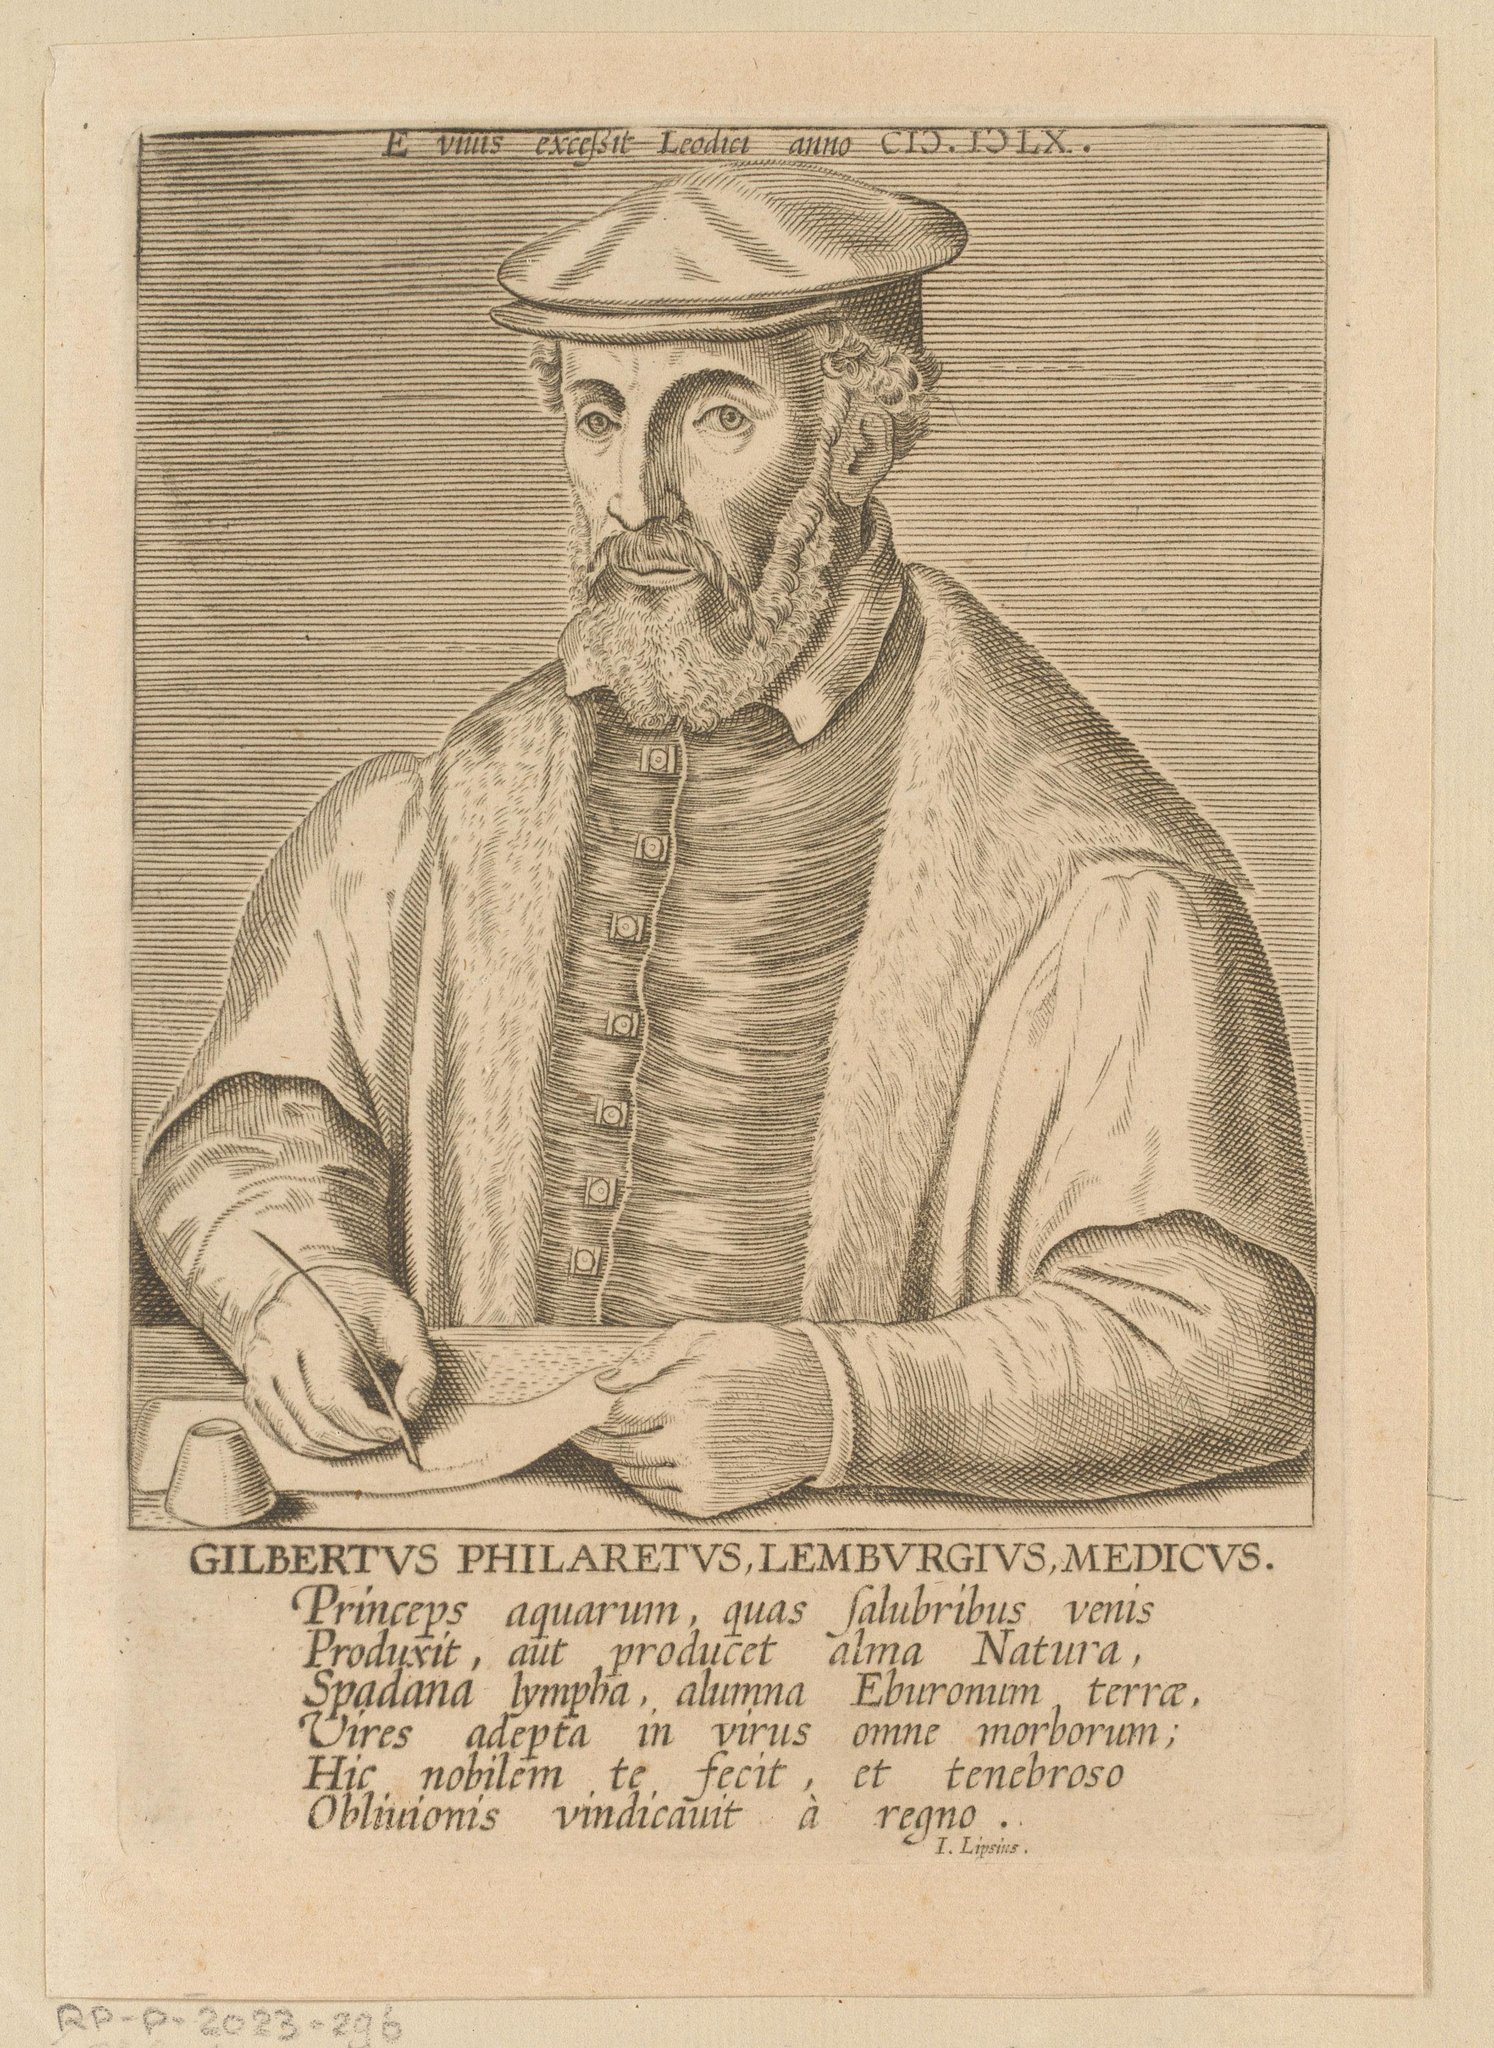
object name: book illustration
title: Bekende schrijvers uit de Nederlanden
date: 1567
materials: paper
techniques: engraving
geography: brussels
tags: historical persons, physician, doctor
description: Prent waarschijnlijk uit: Foppens, Johannes Franciscus. Bibliotheca Belgica (...). Brussel: Peter Foppens, 1739.